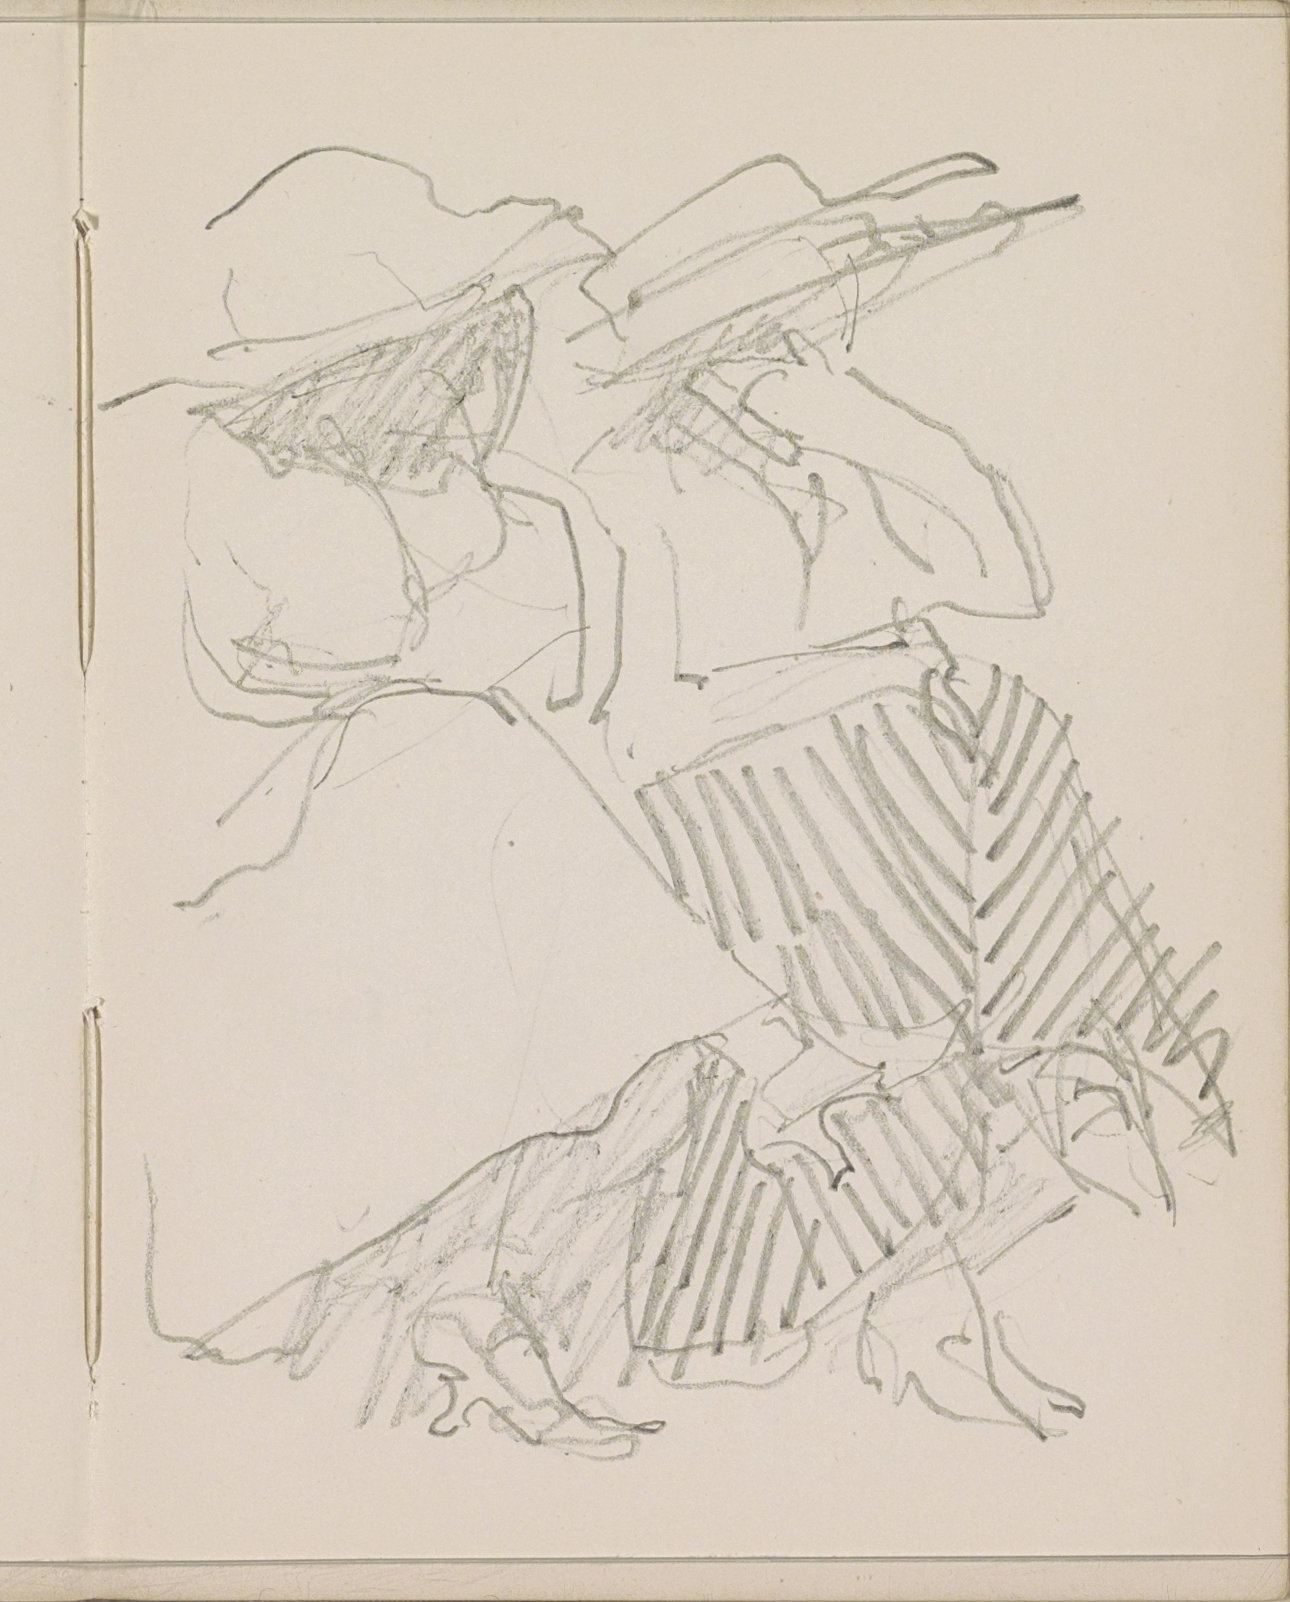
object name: sketchbook leaf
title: Twee zittende vrouwen in lange jurken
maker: reijer stolk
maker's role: draughtsman, print maker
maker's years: 1896-1945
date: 1916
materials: paper, pencil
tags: sitting figure - aa - female human figure, standing, leaning, sitting or lying with legs crossed - aa - female human figure, head-gear: hat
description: De vrouwen dragen allebei een hoed en hebben de benen over elkaar geslagen. Blad 40 recto uit een schetsboek met 72 bladen.